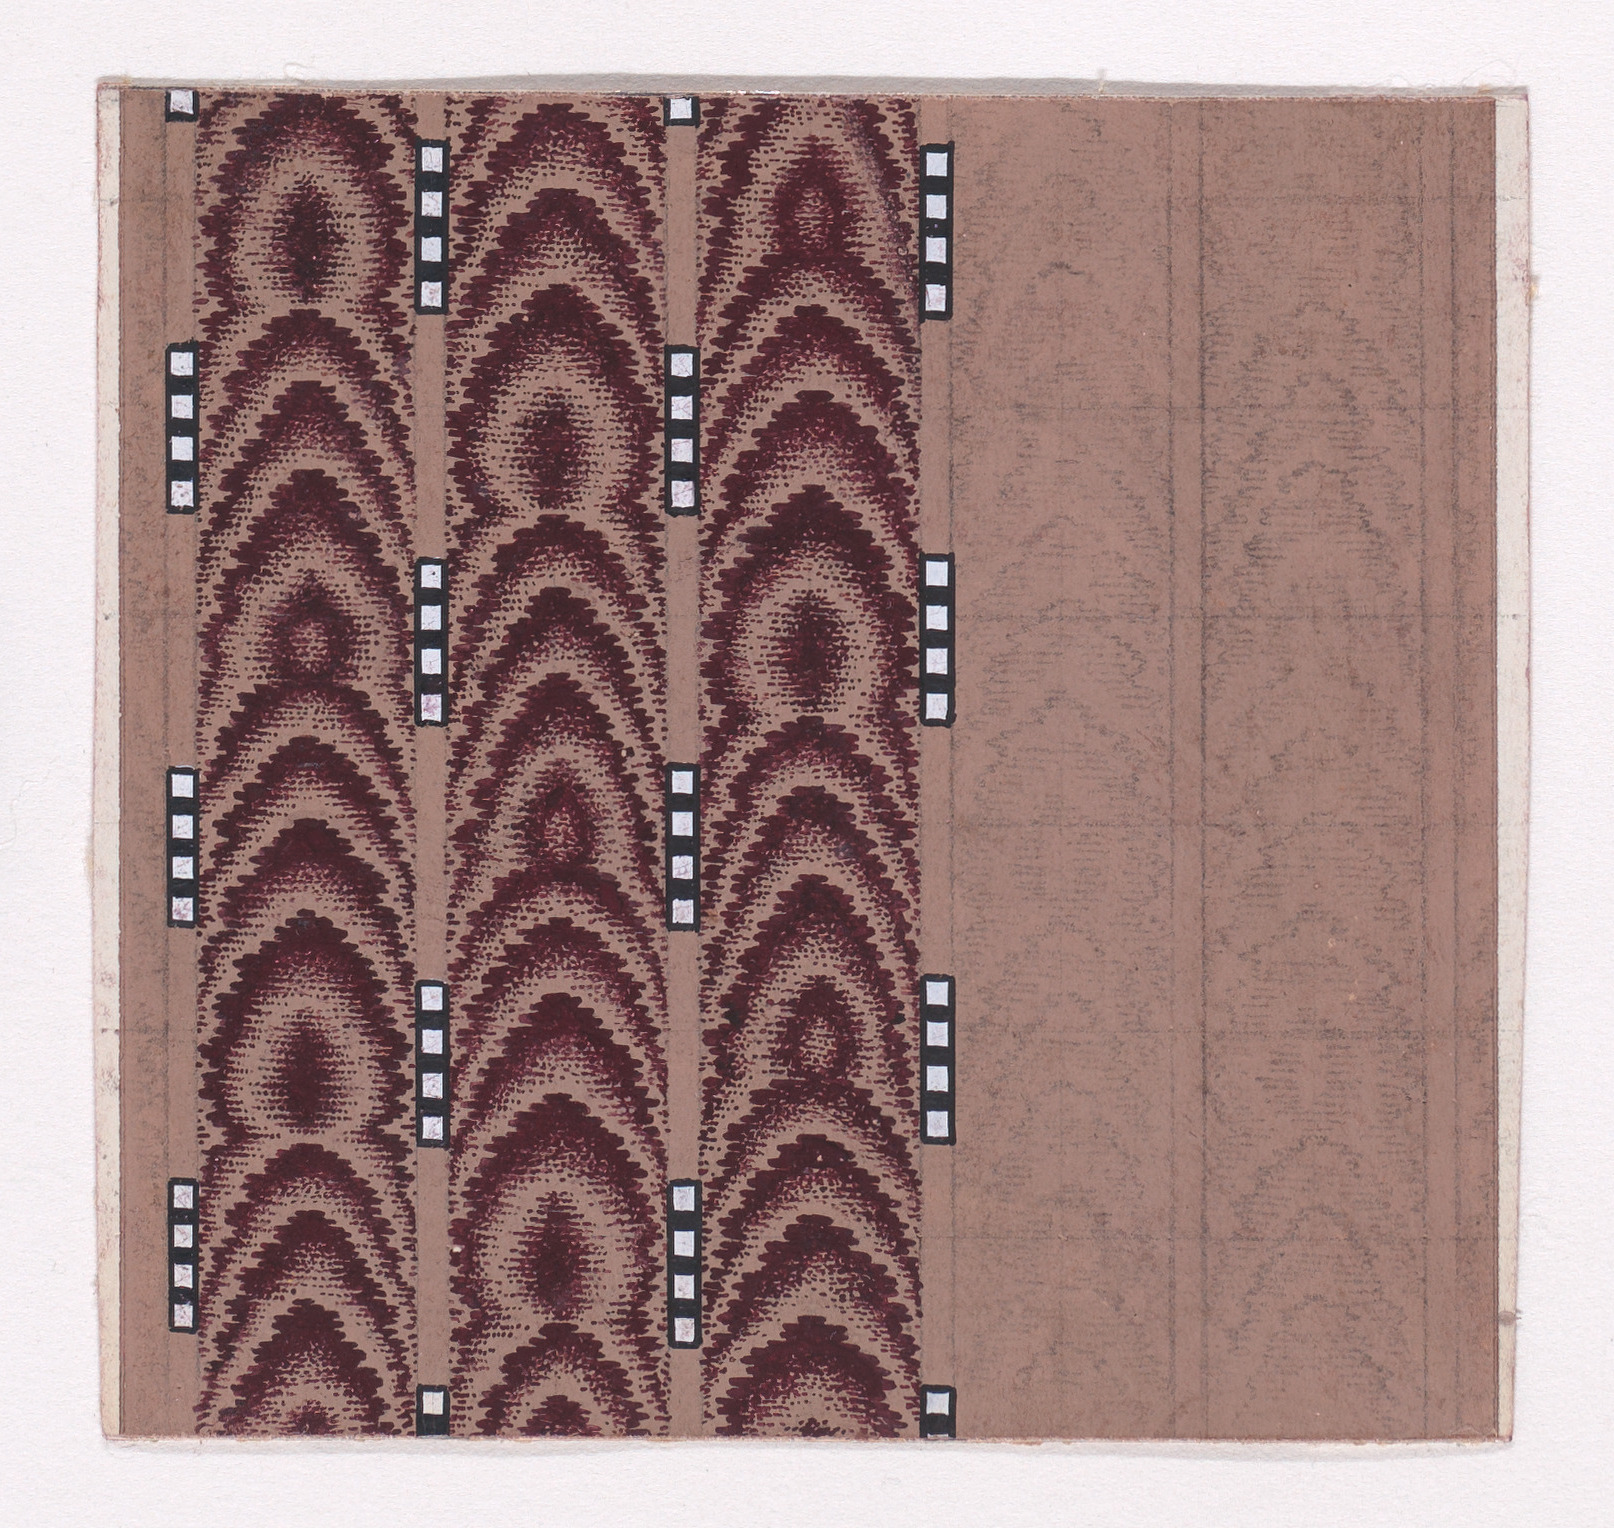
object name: drawing ornament architecture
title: Textile Design of Vertical Stripes of Overlapping Scales Simulating Tie-Dye Framed by Alternating Vertical Strings of Squares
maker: anonymous, alsatian, 19th century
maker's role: artist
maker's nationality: alsatian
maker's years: 1800-1900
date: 1840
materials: gouache